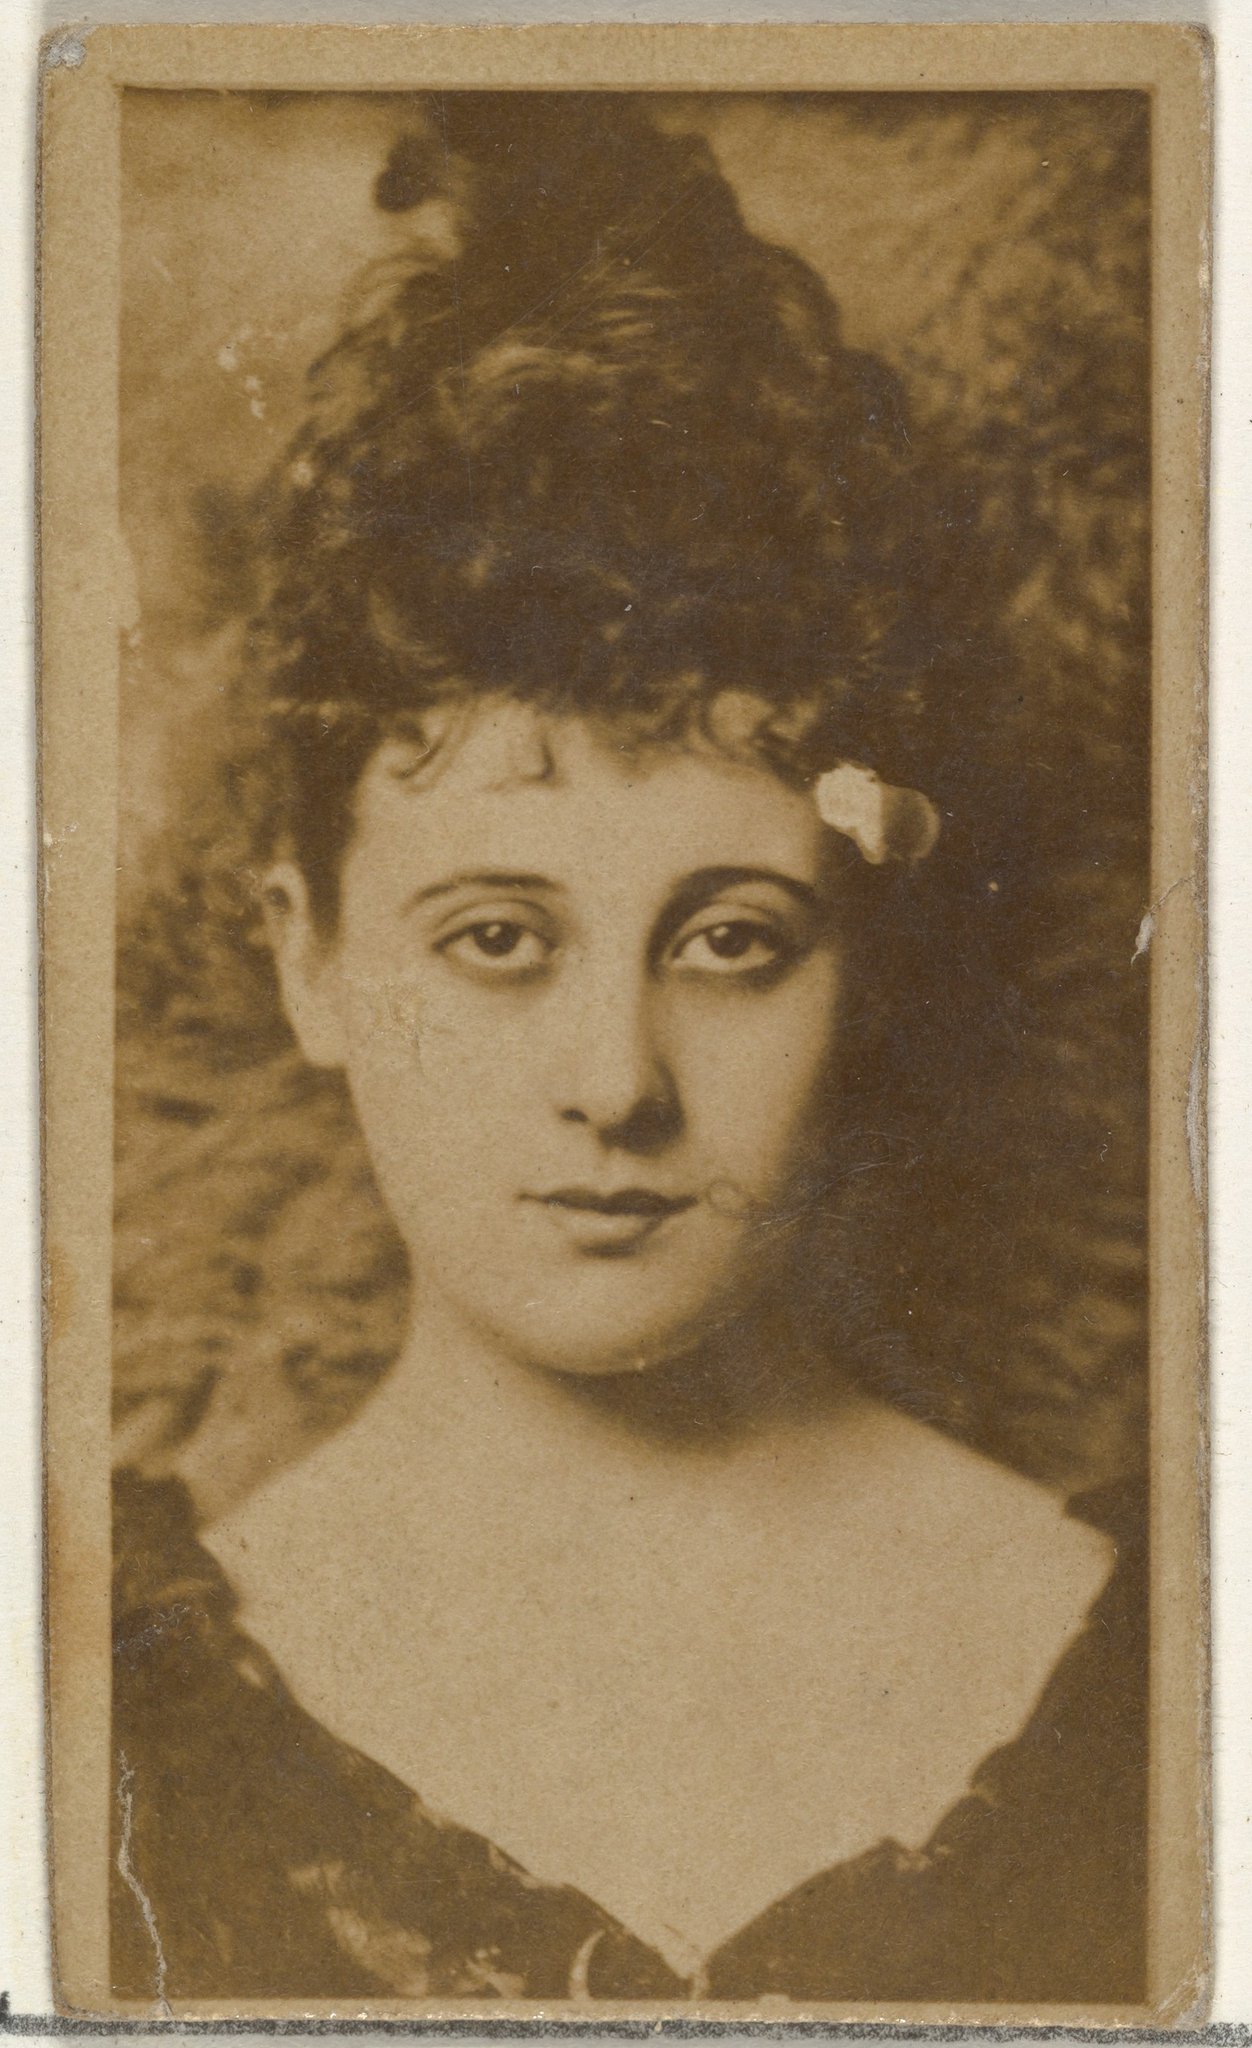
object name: photograph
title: [Actress with dark hair piled on head], from the Actors and Actresses series (N145-8) issued by Duke Sons & Co. to promote Duke Cigarettes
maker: w. duke, sons & co.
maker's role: publisher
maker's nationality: american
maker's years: 1870-1920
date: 1891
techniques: albumen silver print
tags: portraits,women,actresses